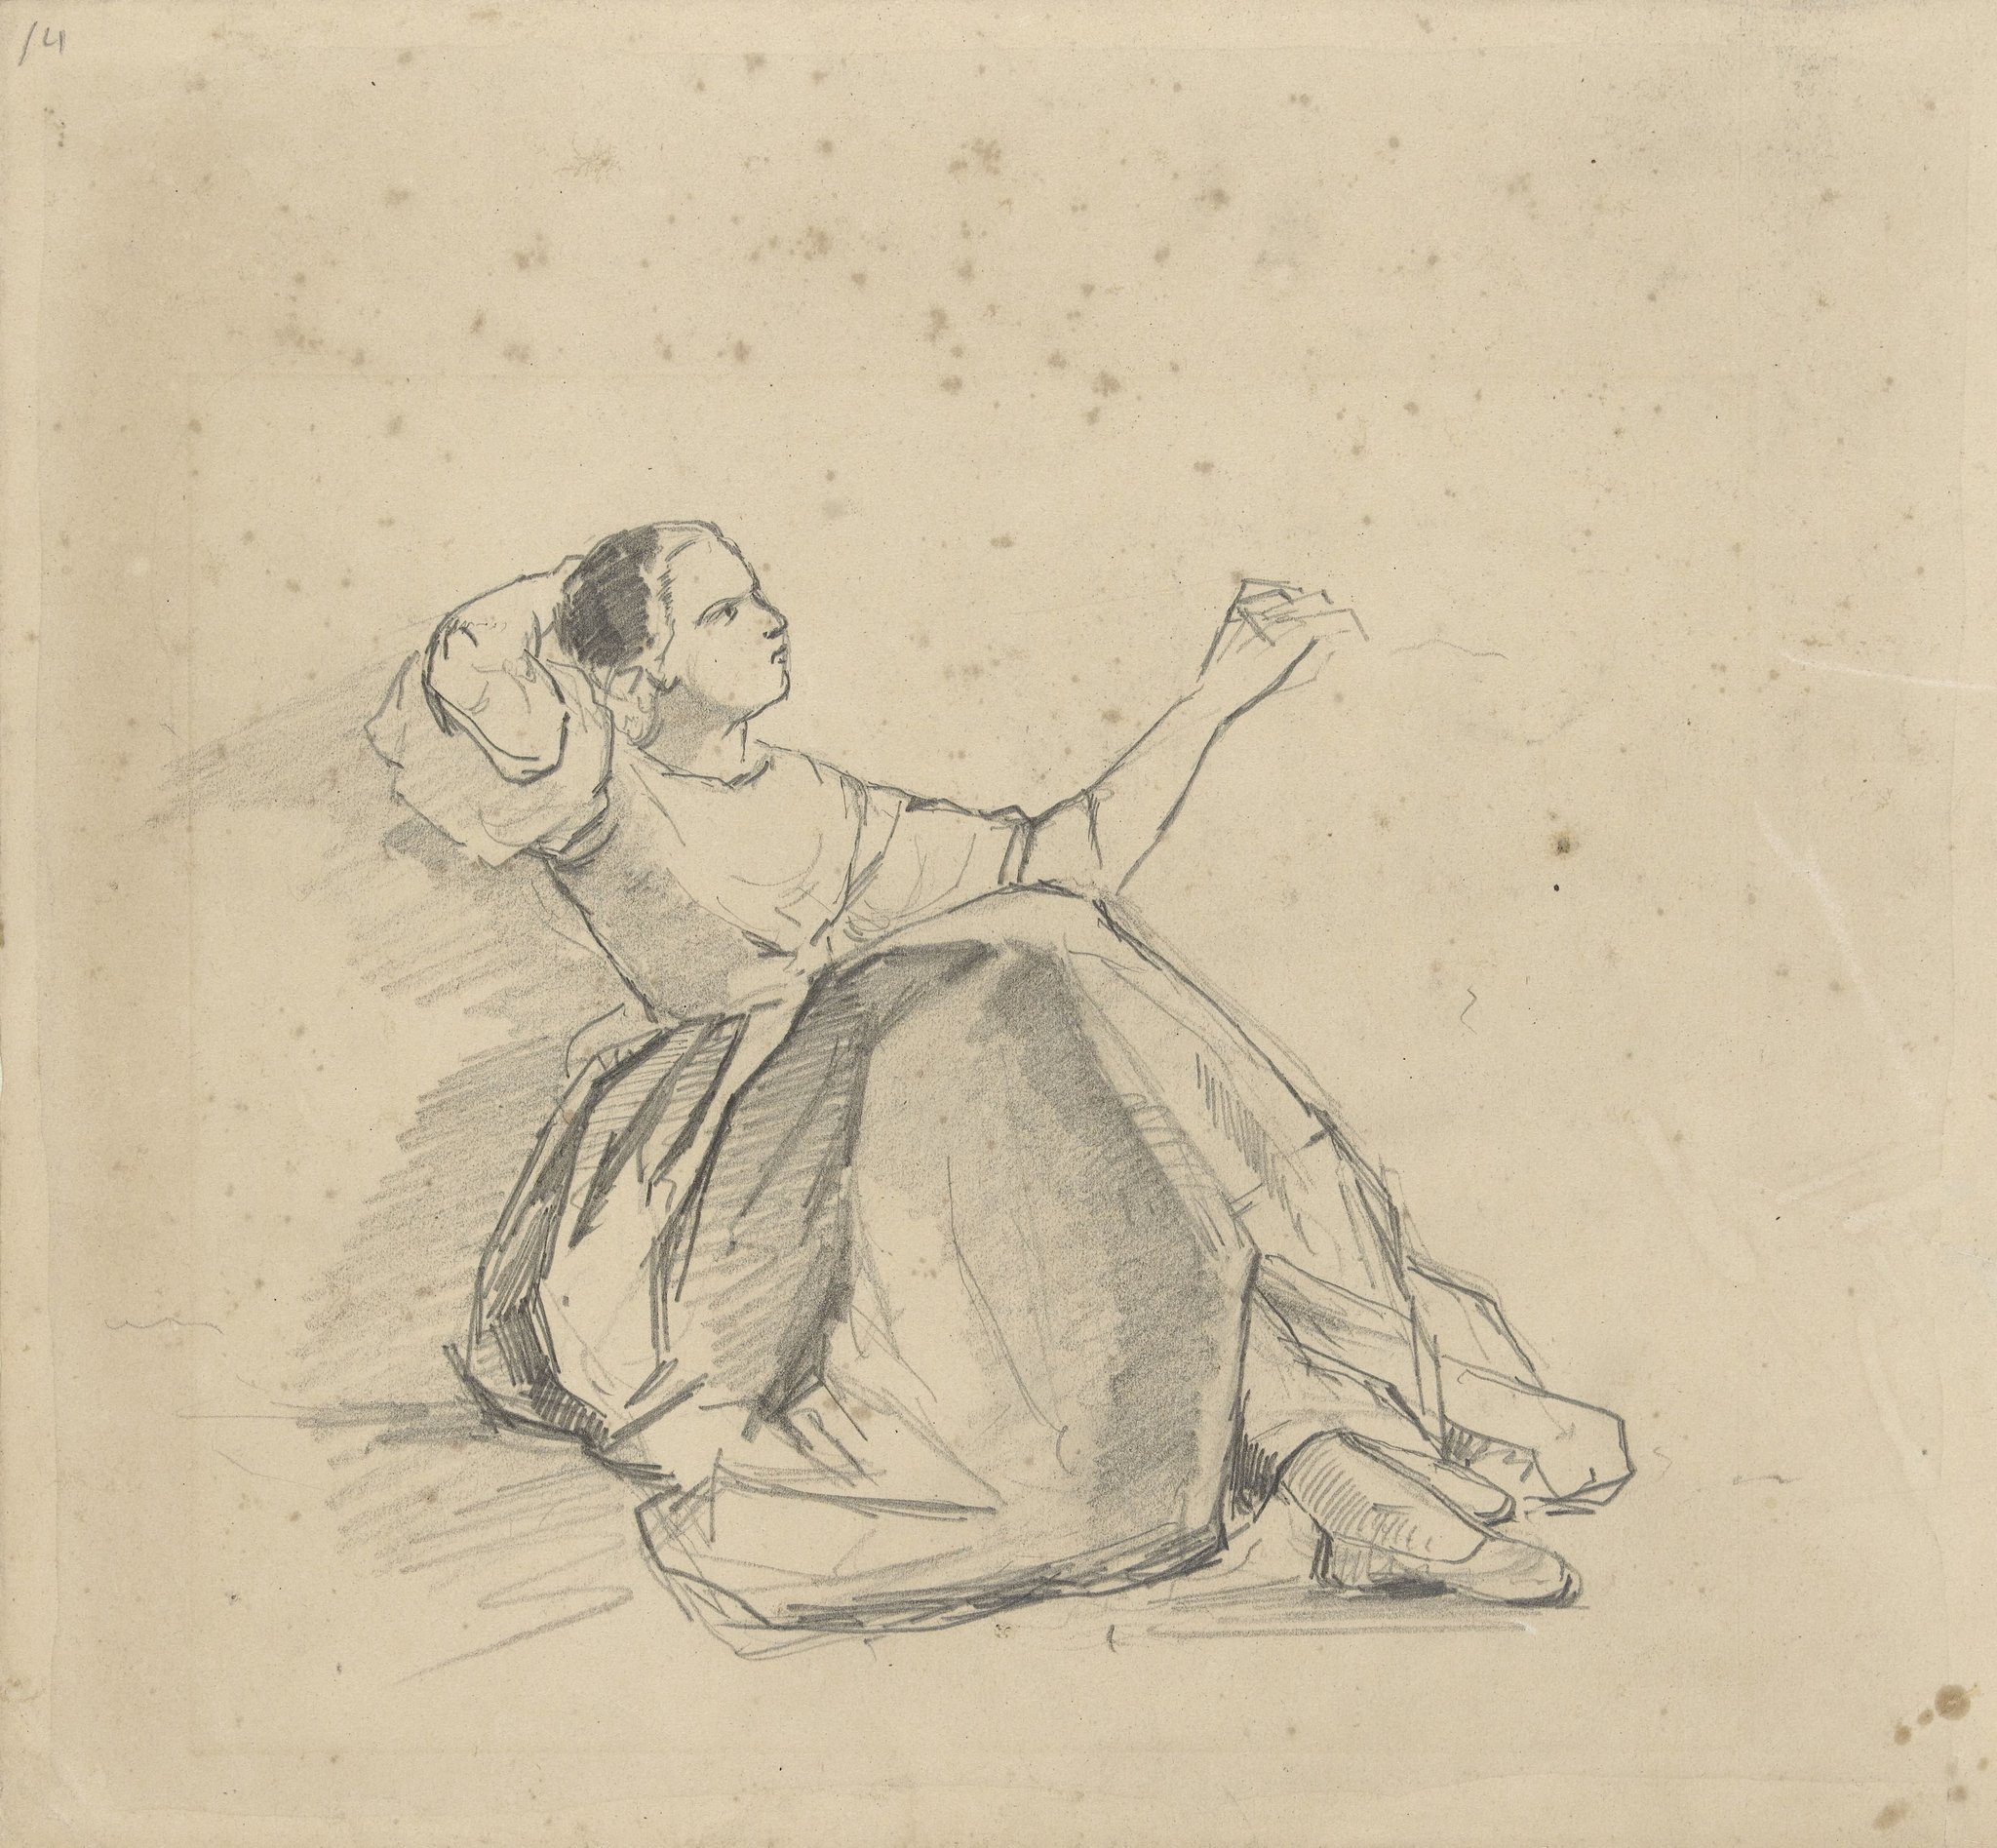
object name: drawing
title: Op de grond zittend meisje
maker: gerard bilders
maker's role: draughtsman, print maker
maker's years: 1838-1865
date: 1848-1865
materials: paper, pencil